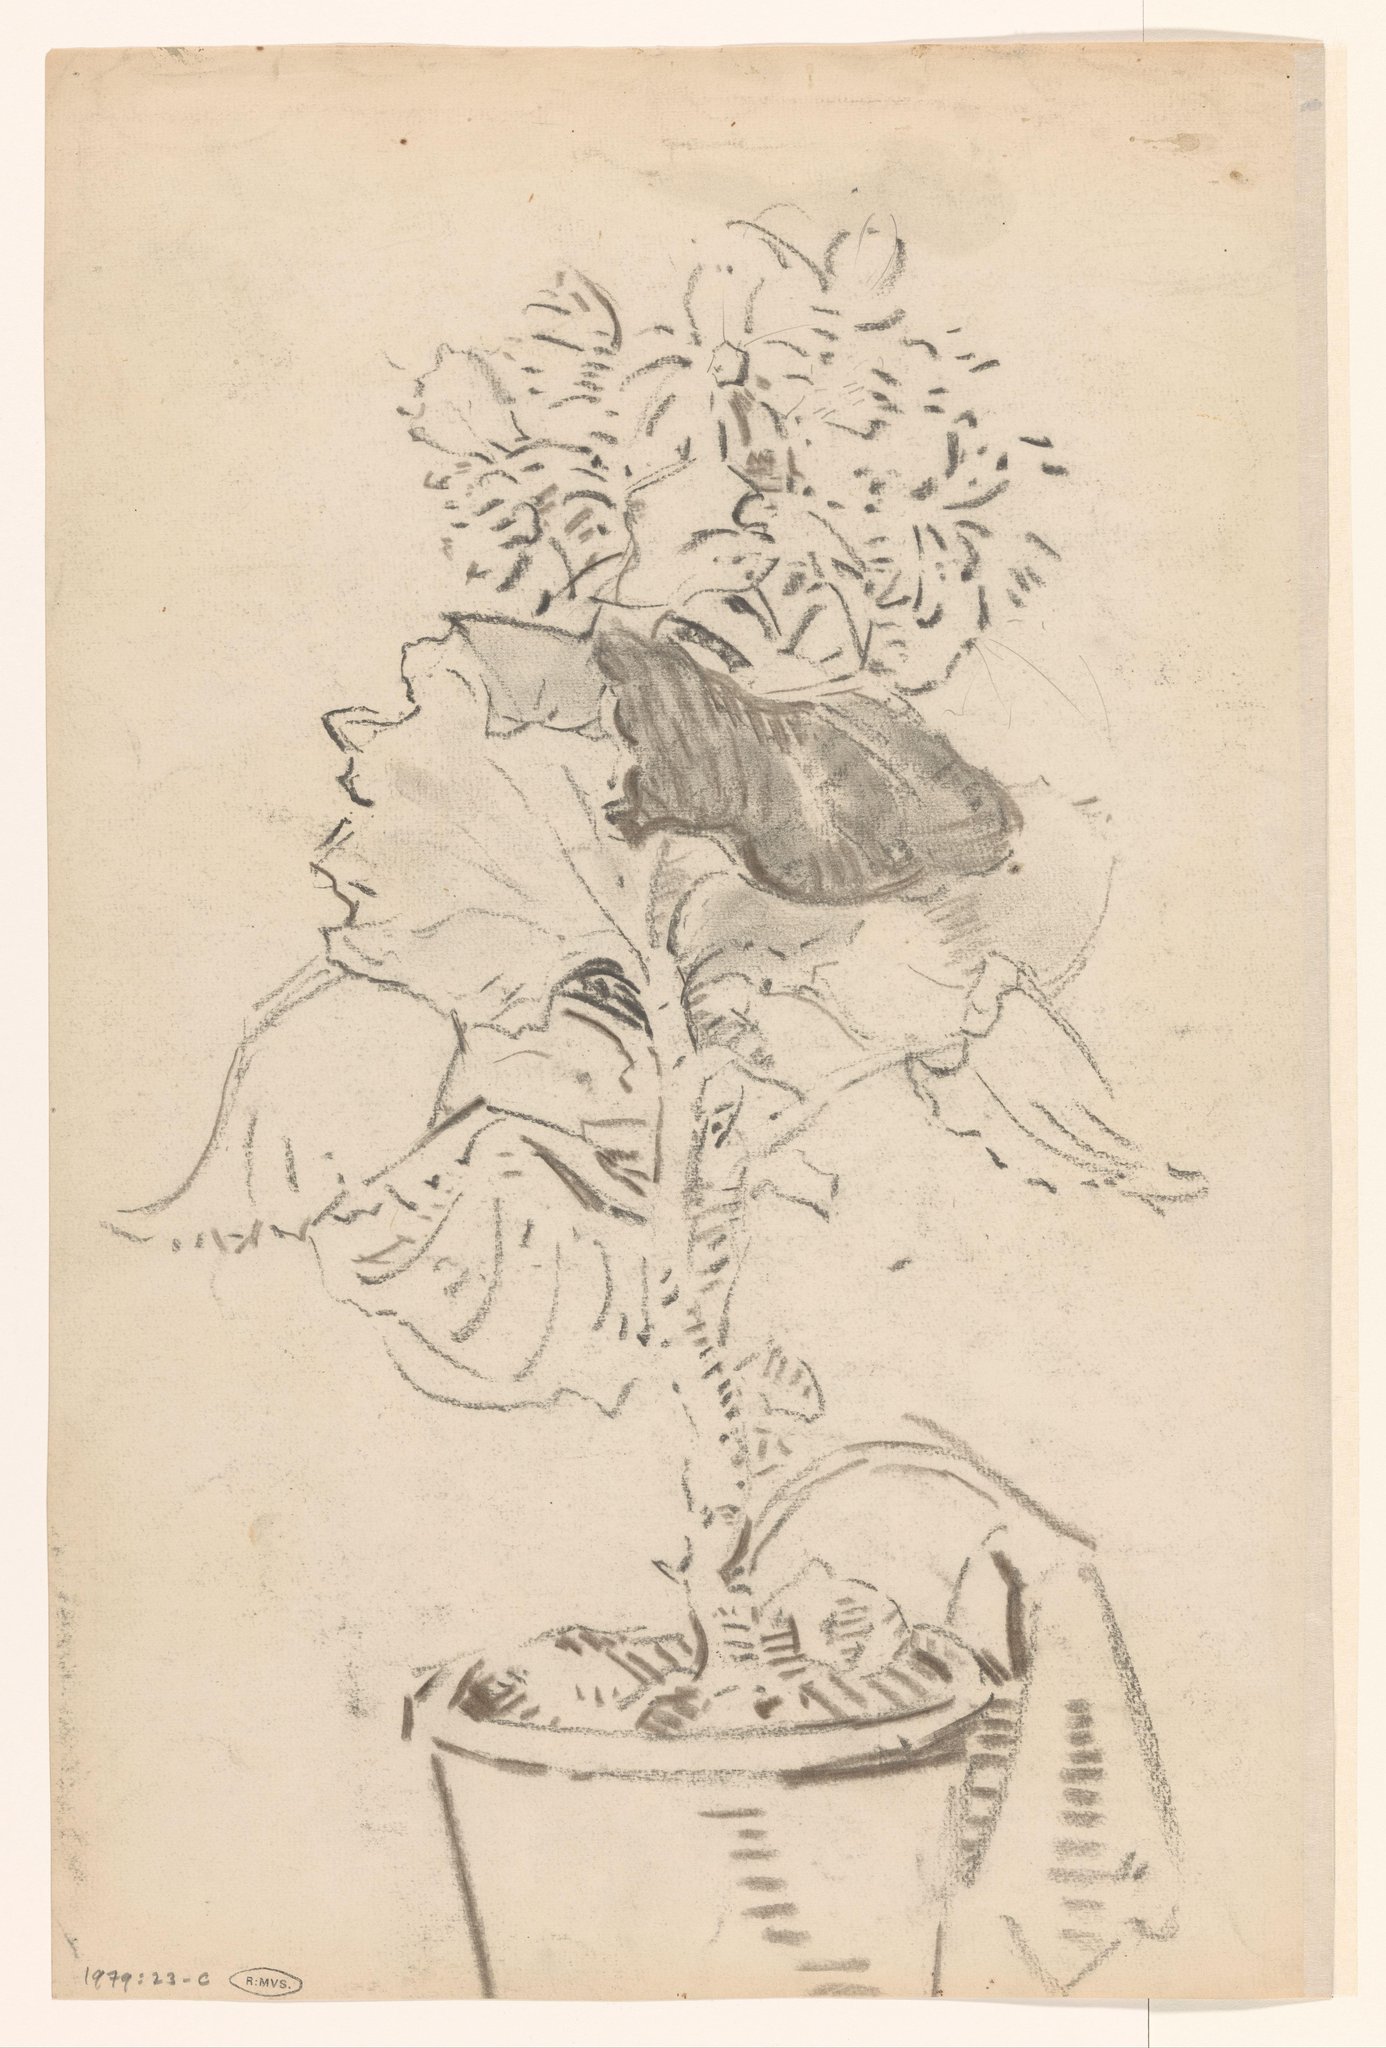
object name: drawing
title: Potplant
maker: wilhelmus johannes steenhoff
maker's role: draughtsman, print maker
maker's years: 1863-1932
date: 1873-1932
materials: chalk, paper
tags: ornamental plants